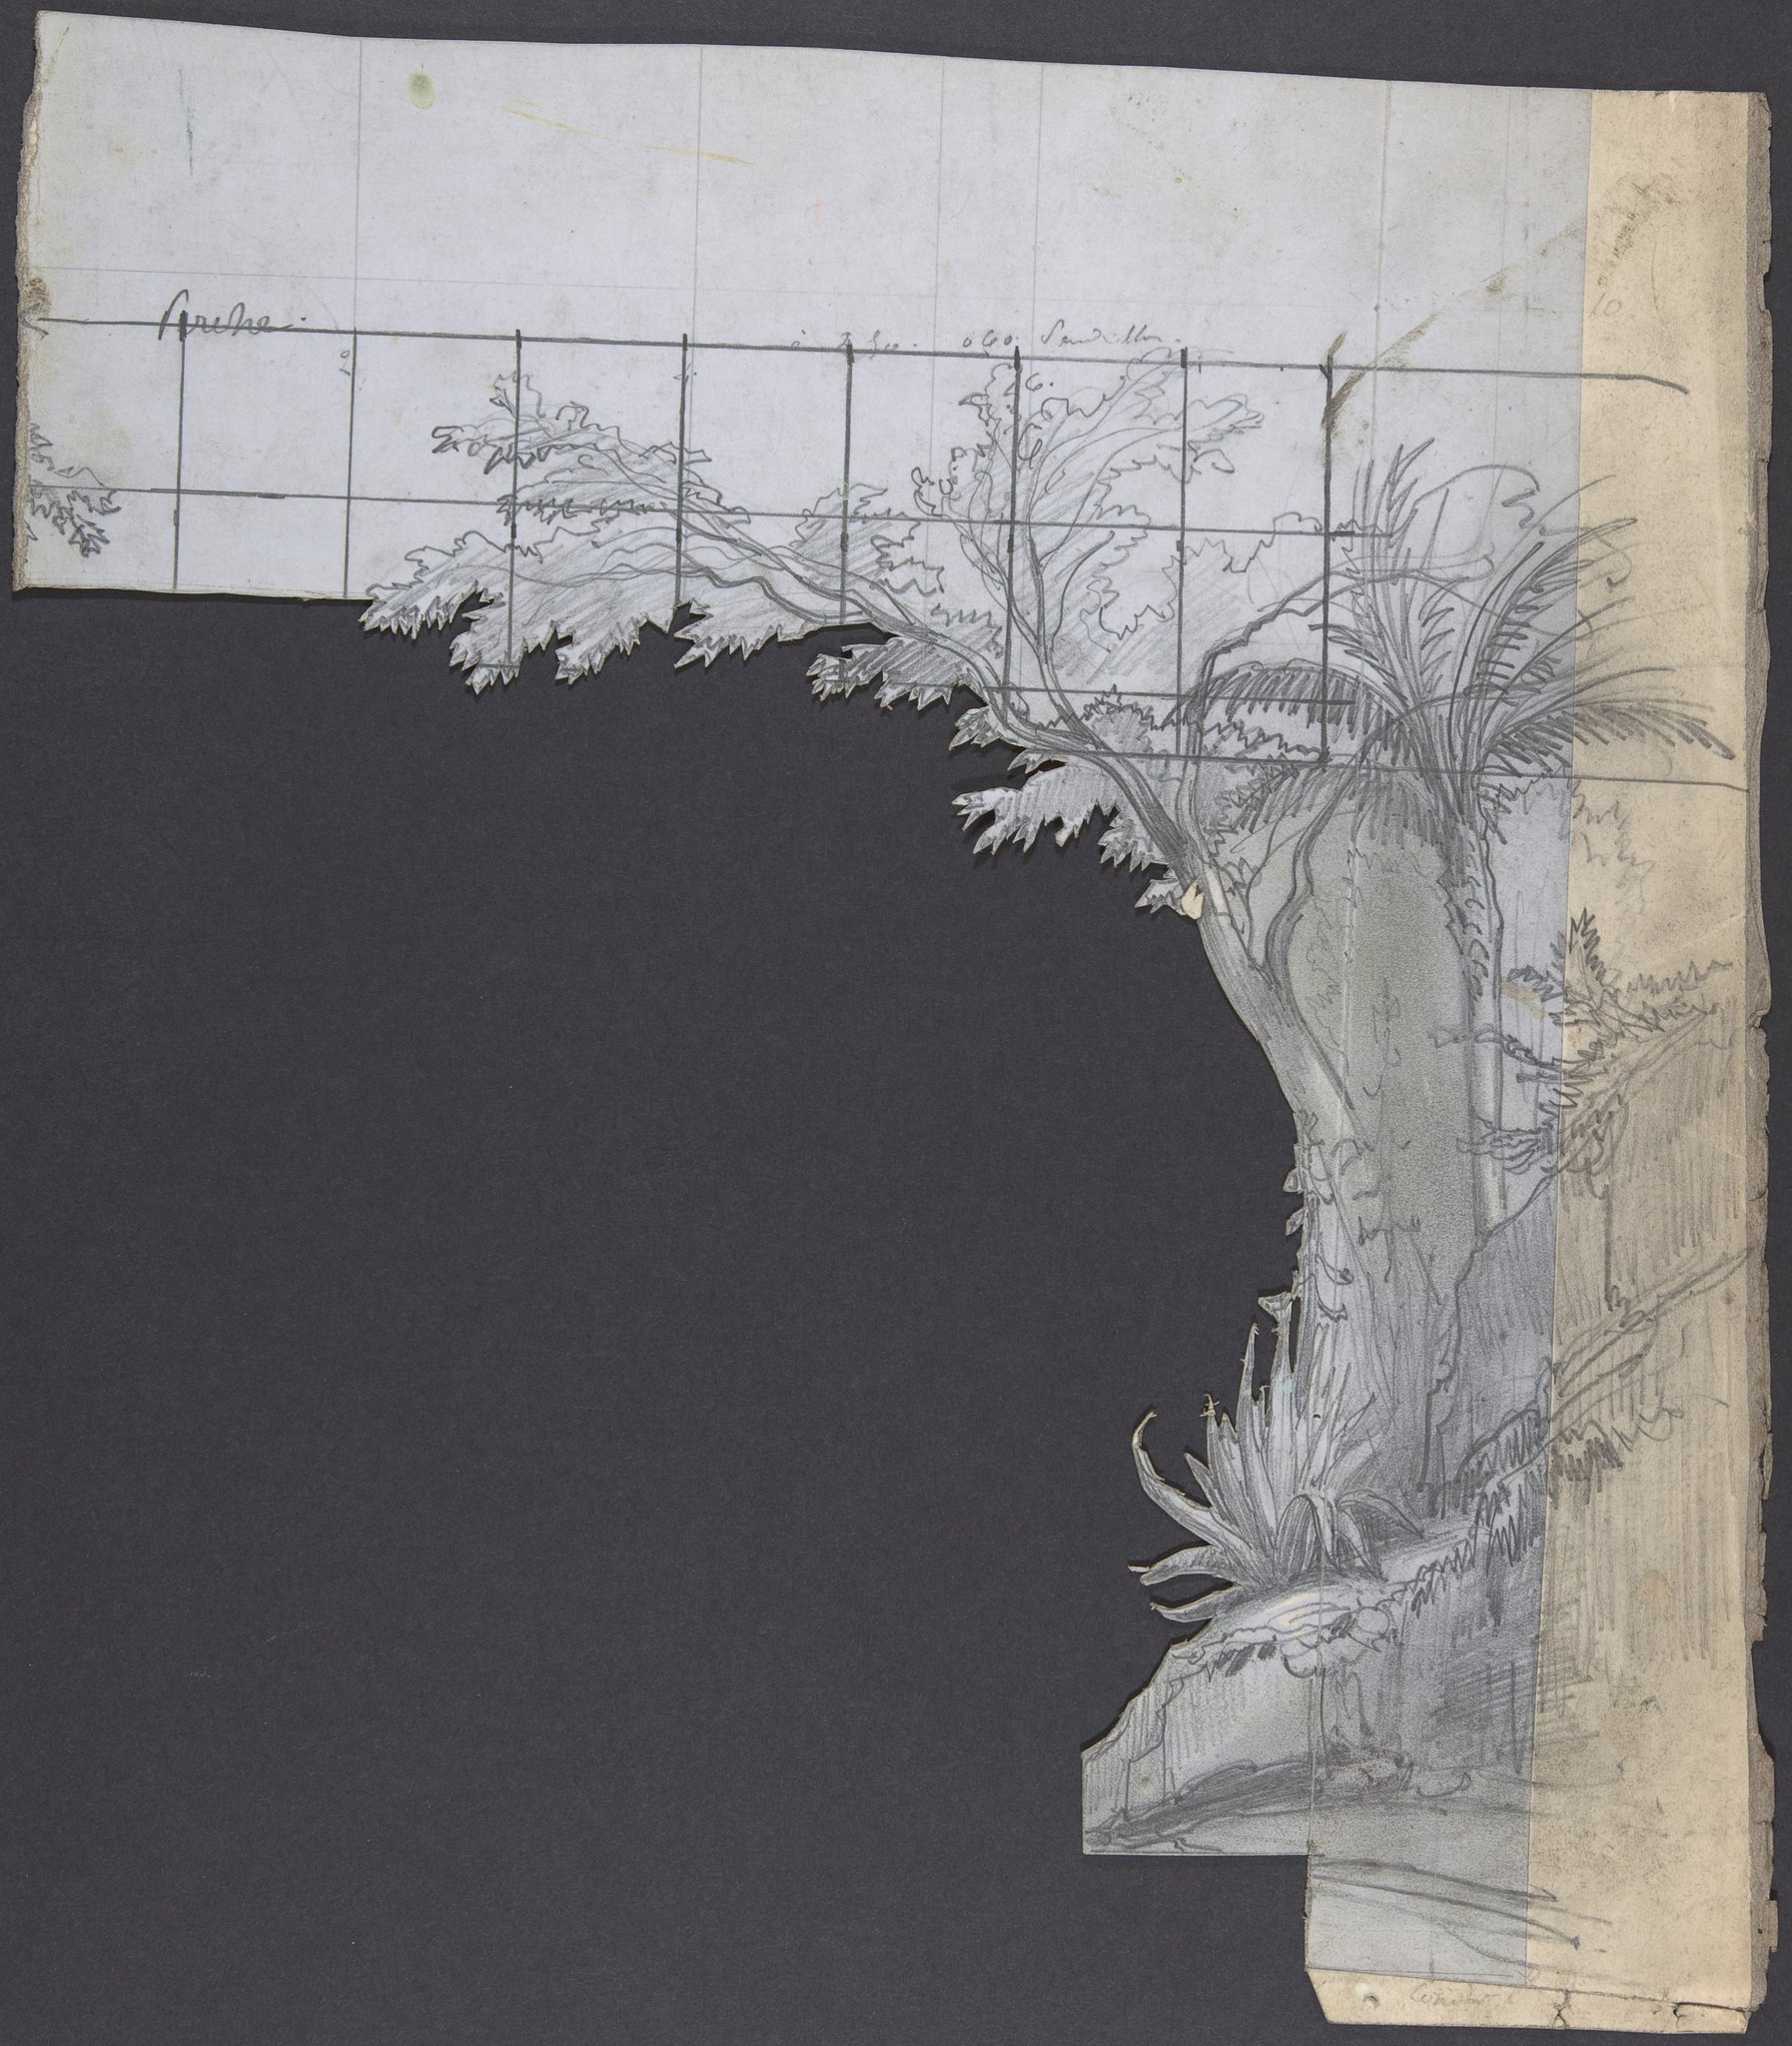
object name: drawing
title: Design for a Stage Set at the Opéra, Paris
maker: eugène cicéri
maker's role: artist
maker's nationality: french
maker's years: 1813-1890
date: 1830-1890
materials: graphite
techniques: heightening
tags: trees,stage design